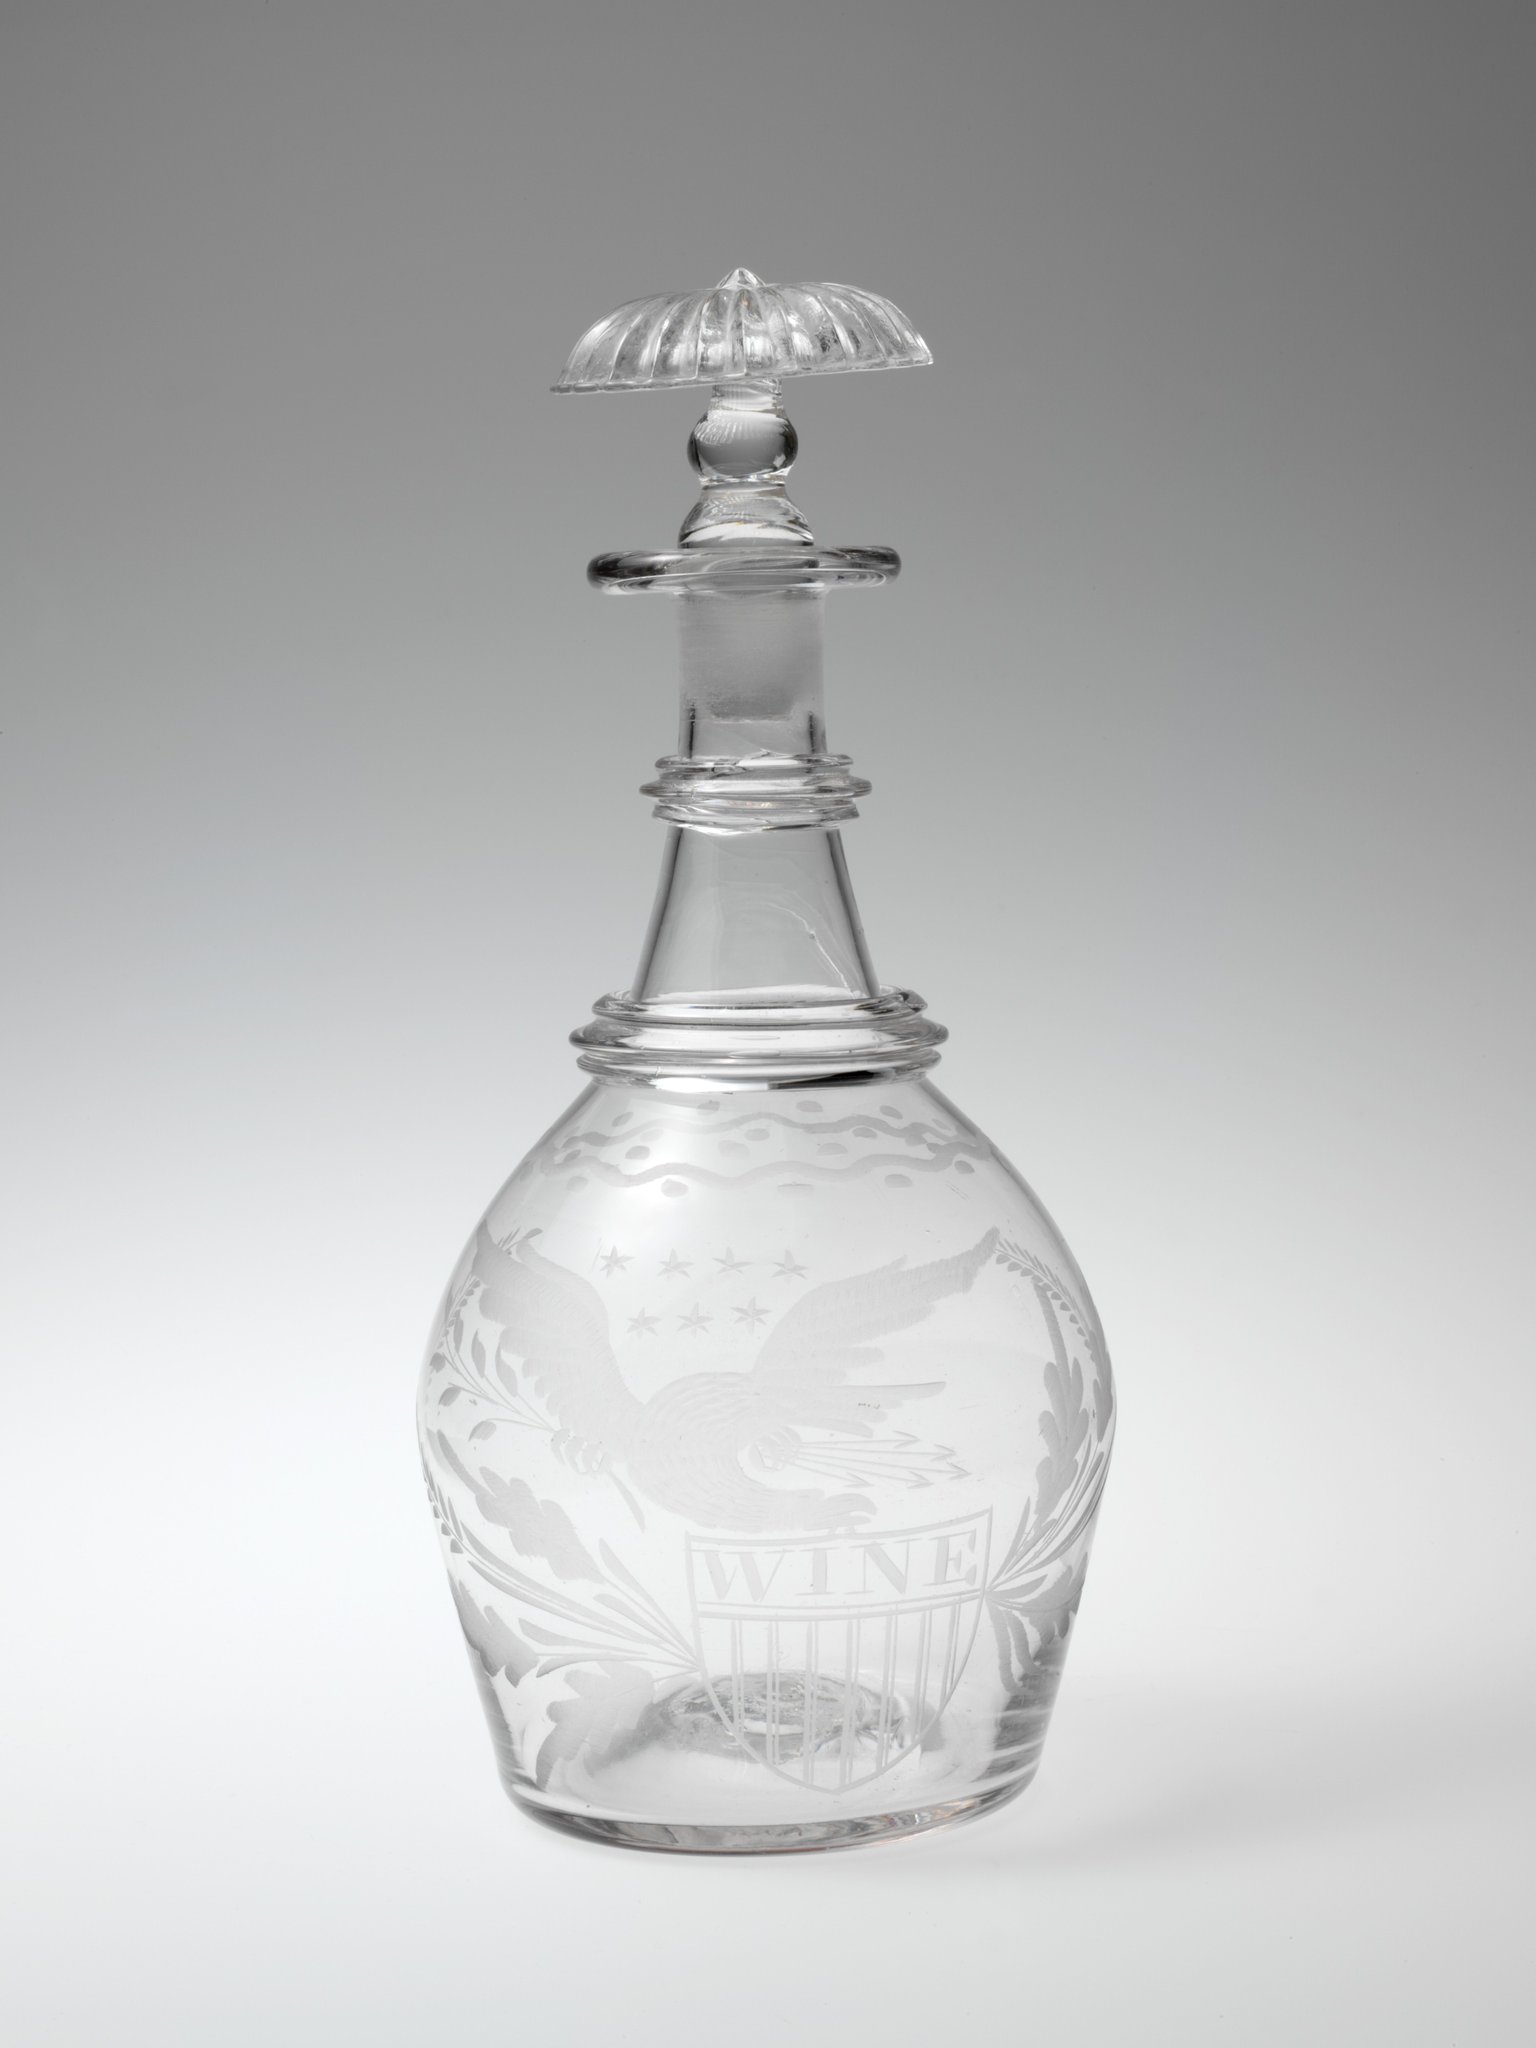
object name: decanter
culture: american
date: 1815-1835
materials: glass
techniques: glassblowing, engraving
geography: united states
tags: eagles